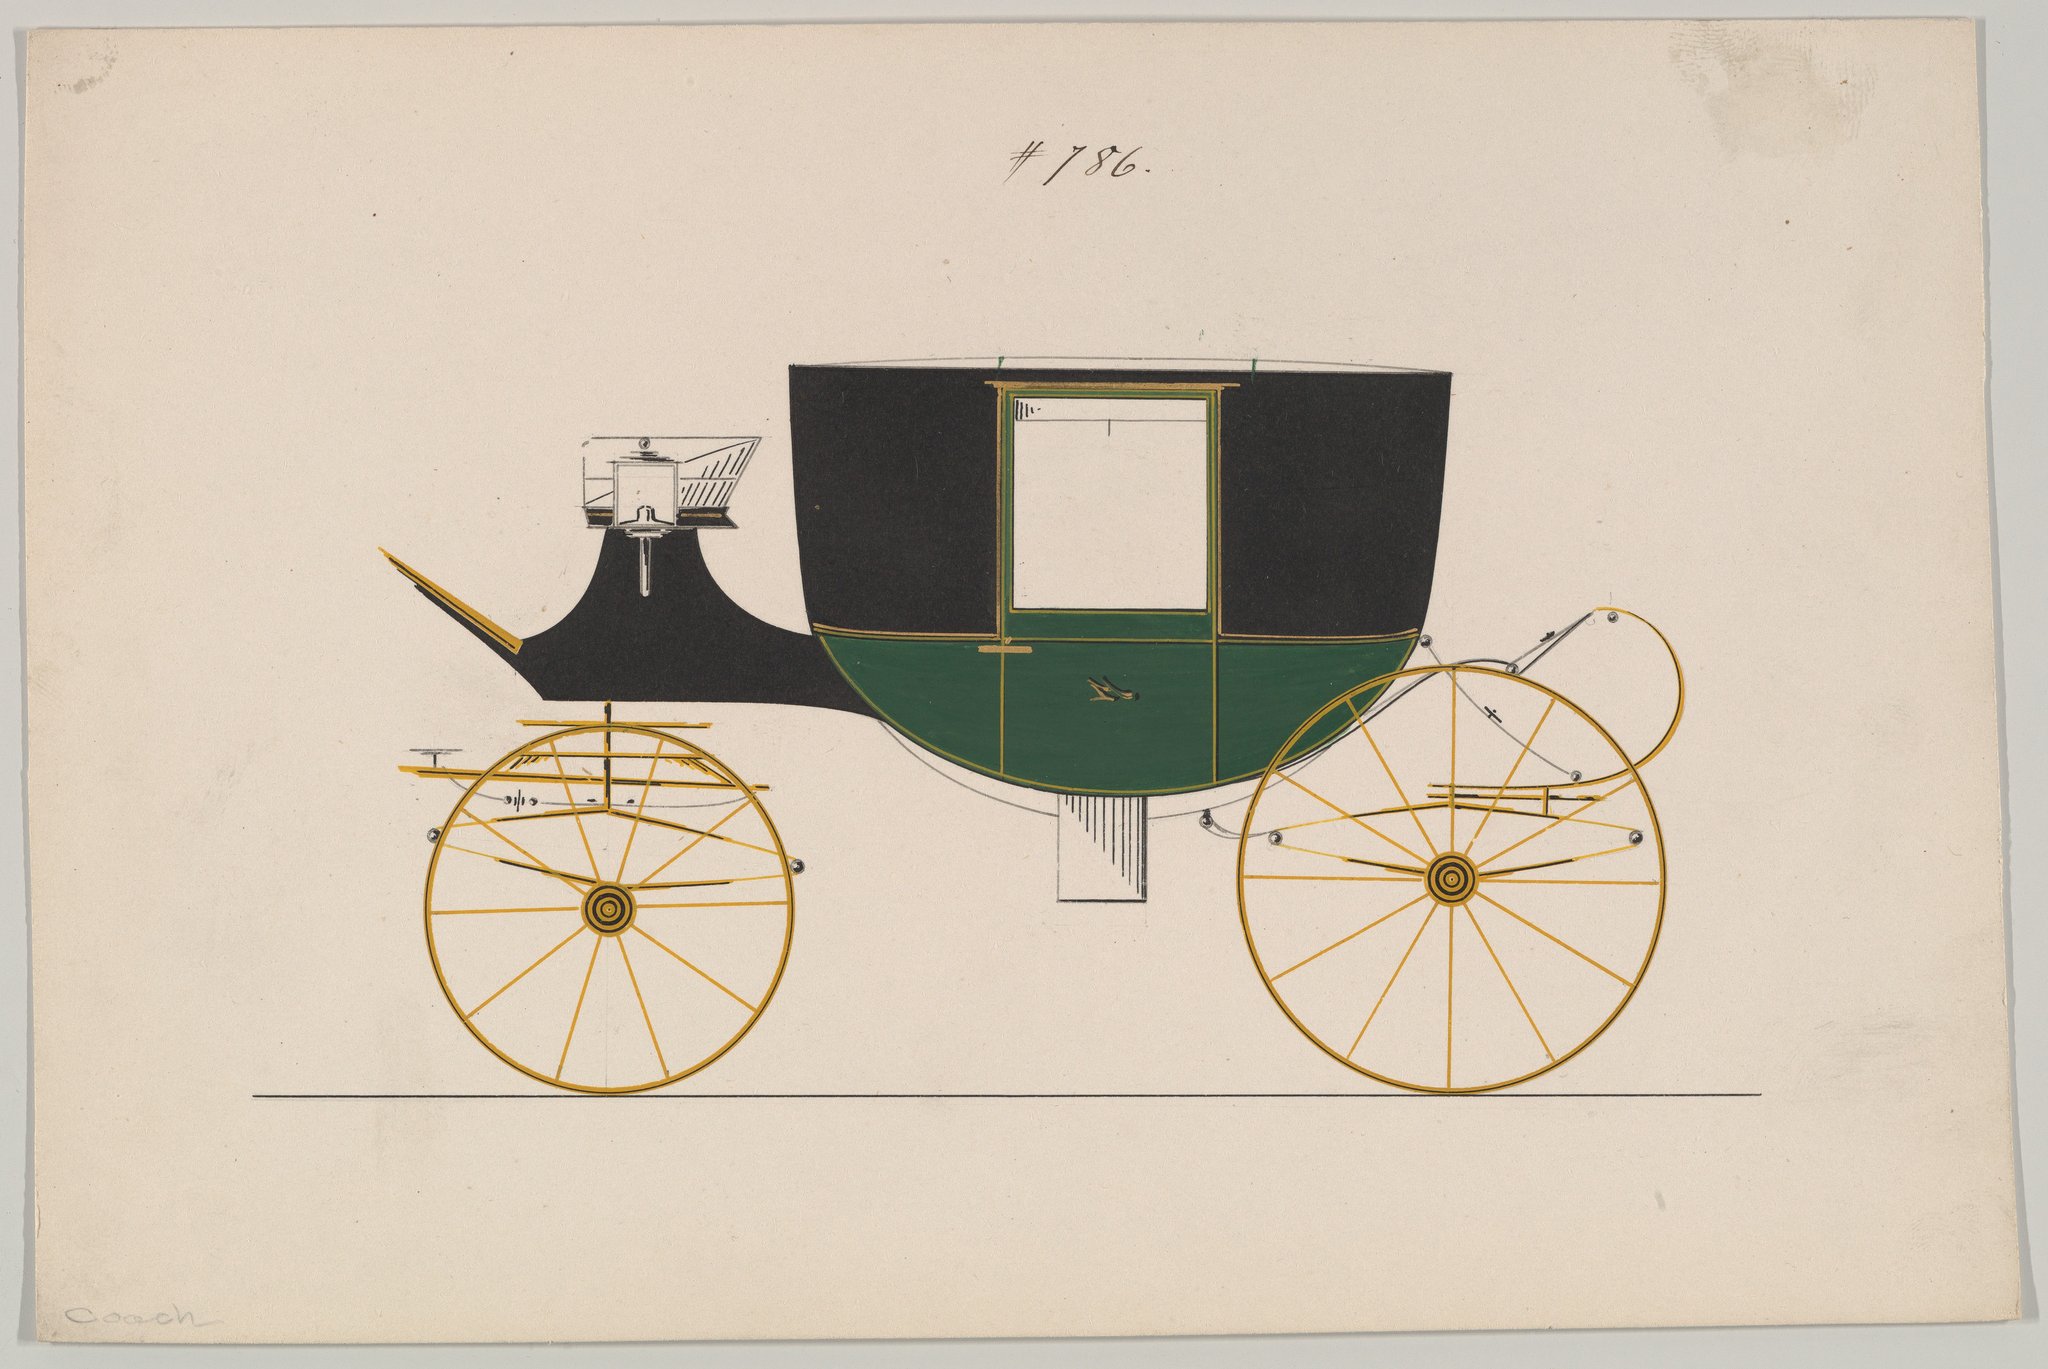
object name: drawing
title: Coach #786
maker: brewster & co.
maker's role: manufacturer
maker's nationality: american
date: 1865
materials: ink, watercolor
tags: carriages